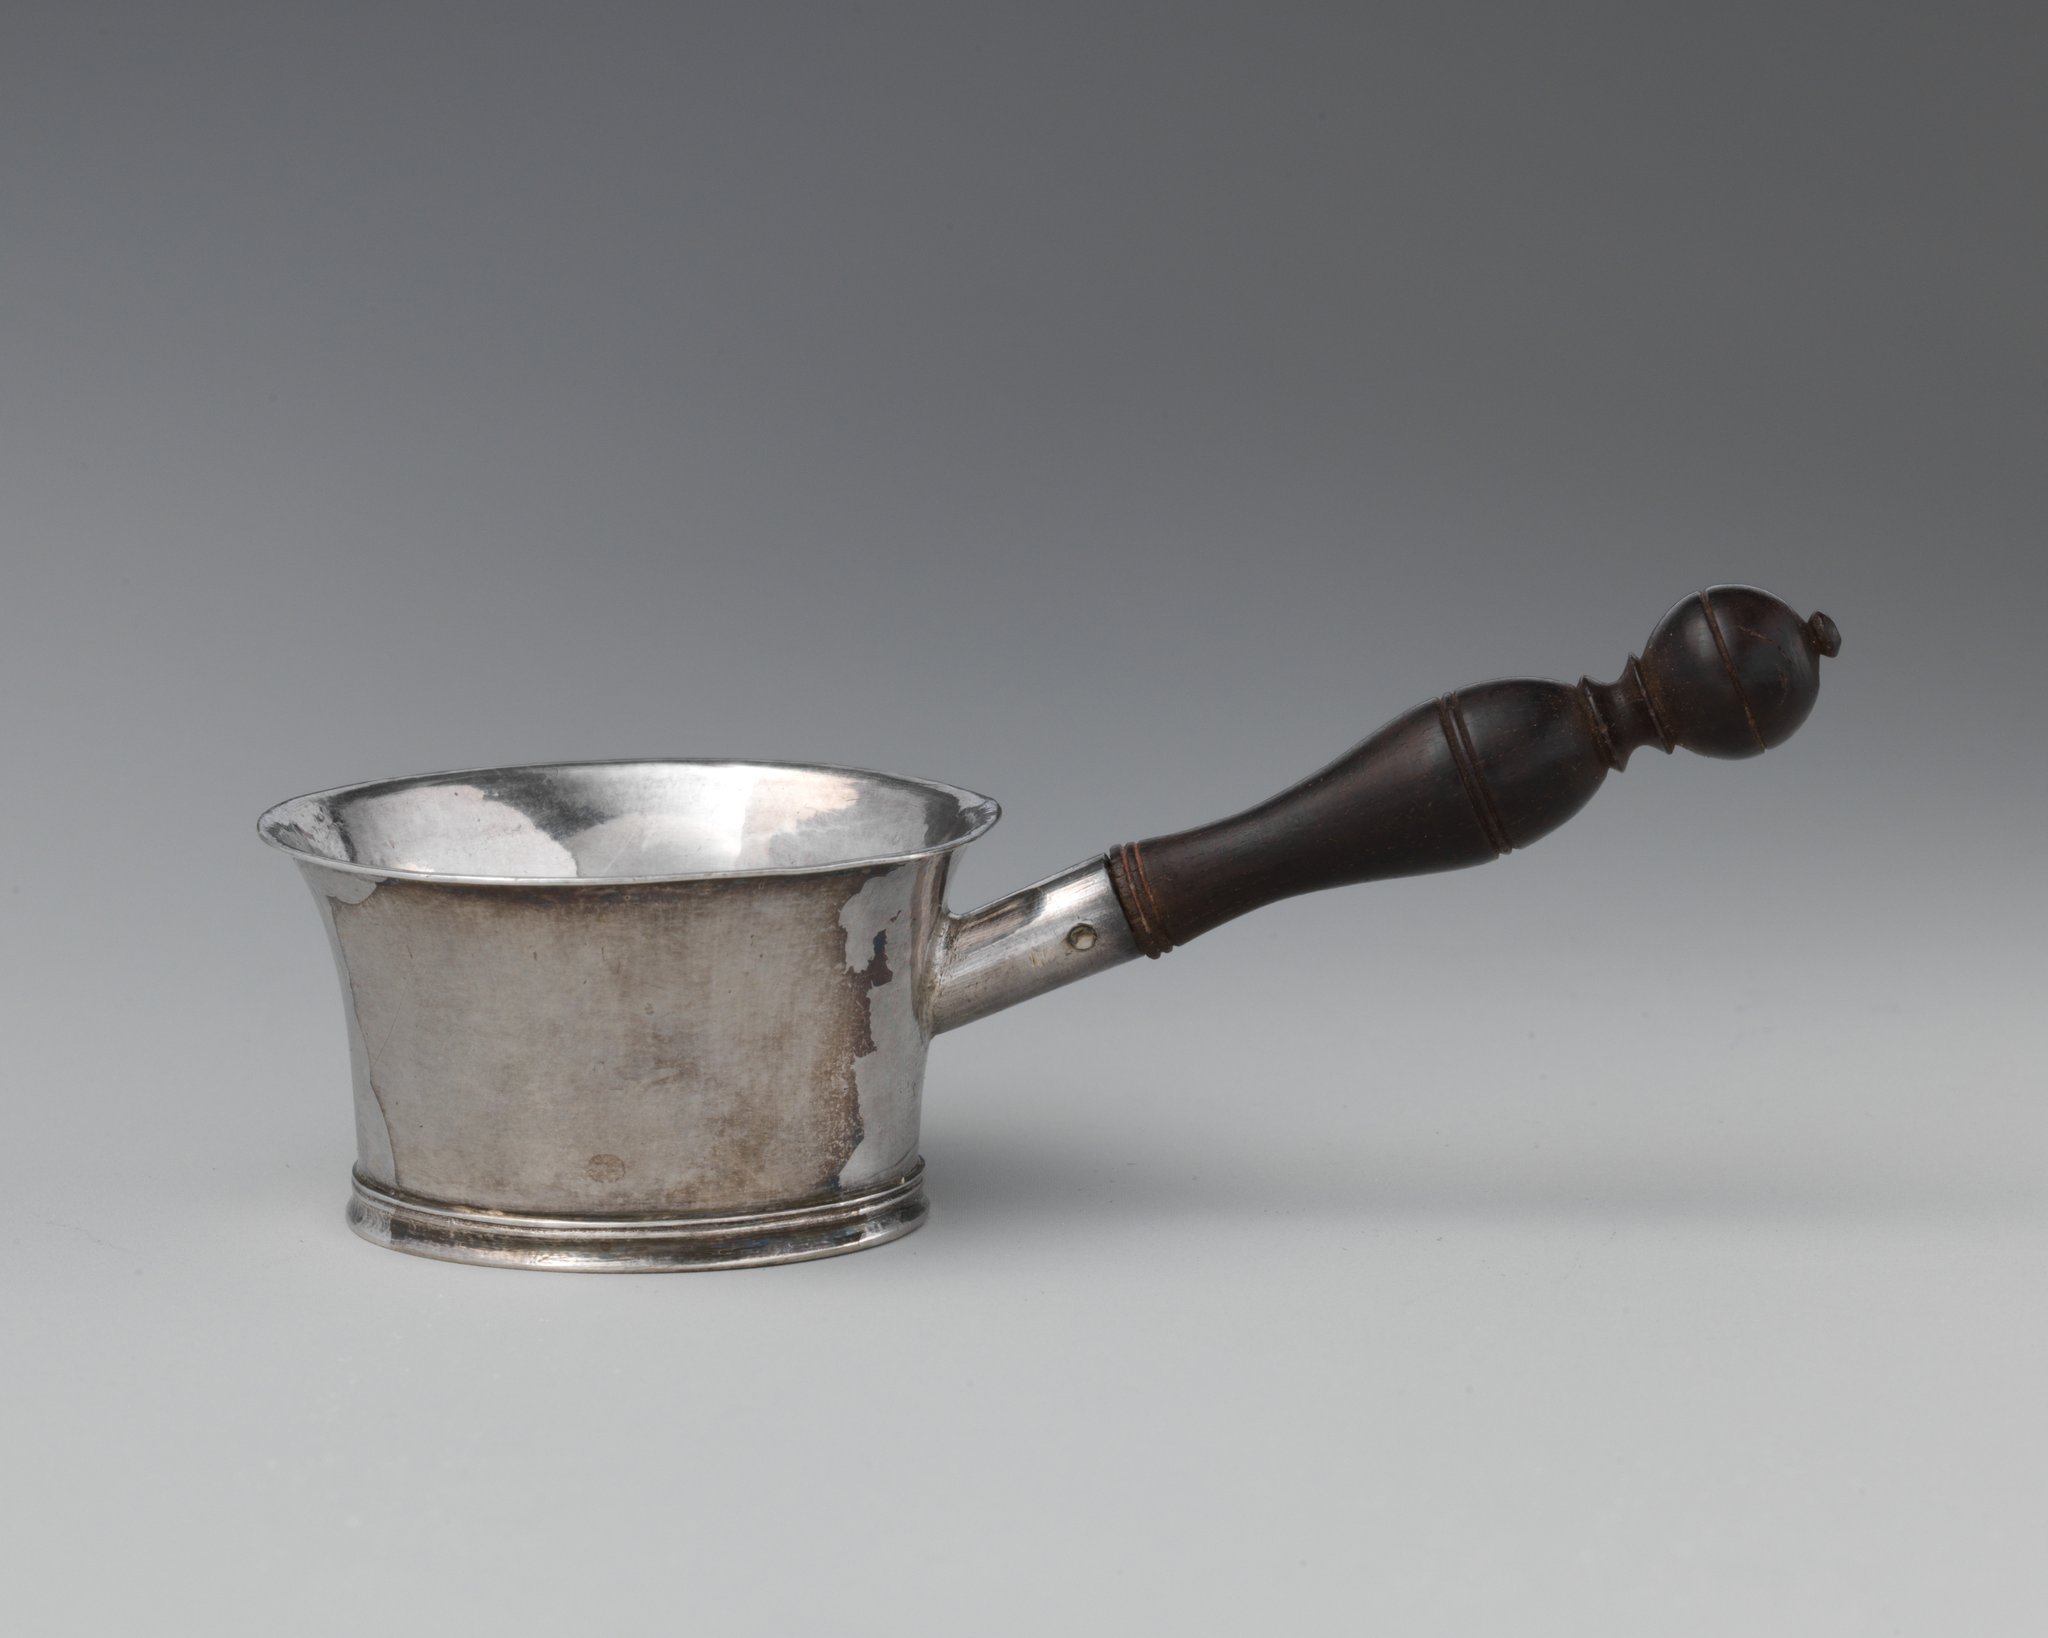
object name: saucepan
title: Miniature saucepan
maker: david clayton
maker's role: artist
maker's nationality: british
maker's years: 1659-1719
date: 1720-1730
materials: wood, silver